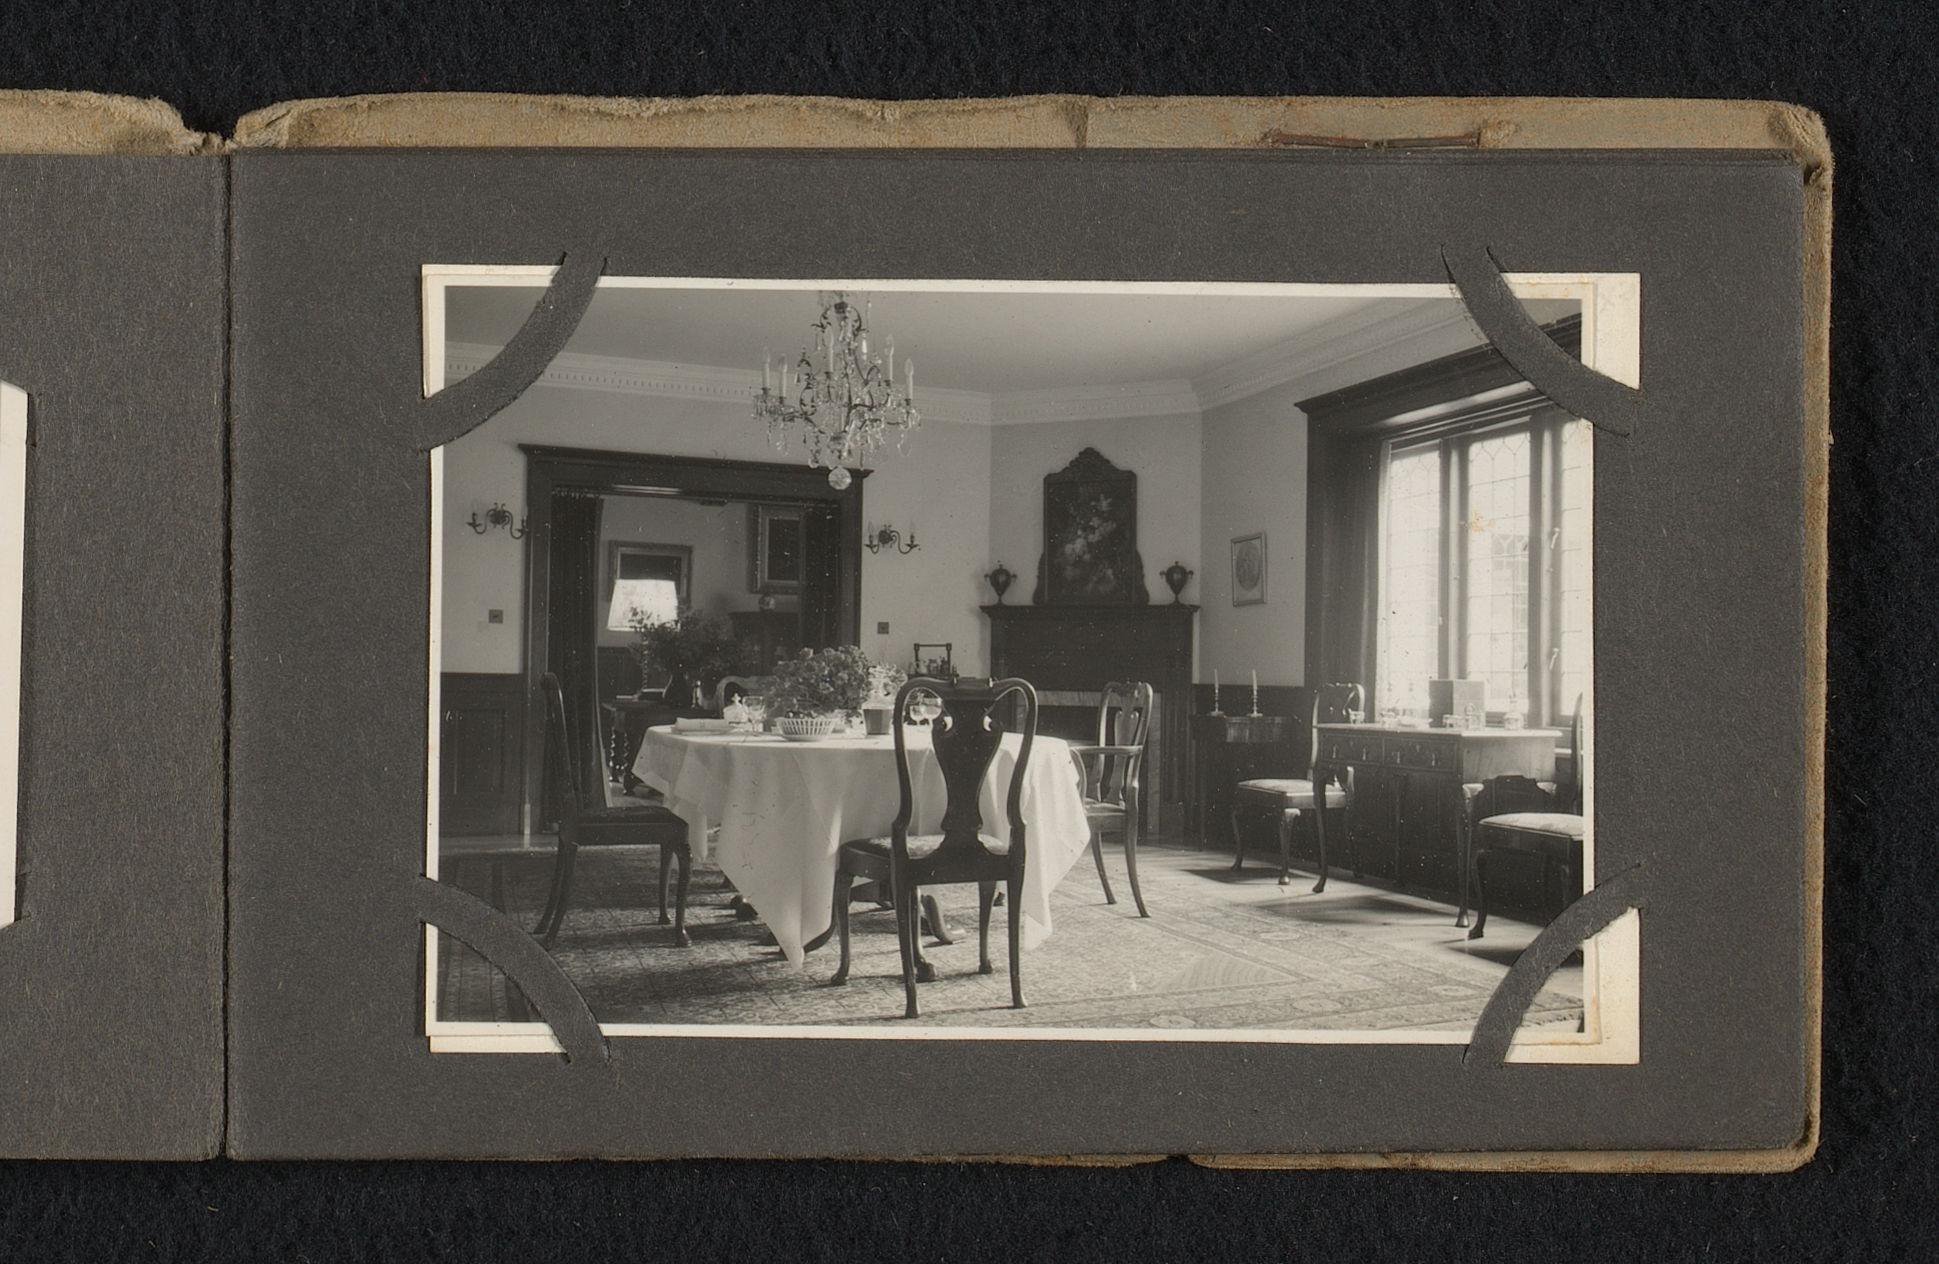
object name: photograph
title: Eetkamer van het landhuis De Wilde Zwanen te Laren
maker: norbert van den berg (1901-1972)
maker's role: amateurfotograaf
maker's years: 1901-1972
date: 1940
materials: paper, cardboard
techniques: gelatin silver print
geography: laren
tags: interior of the house, dining-room